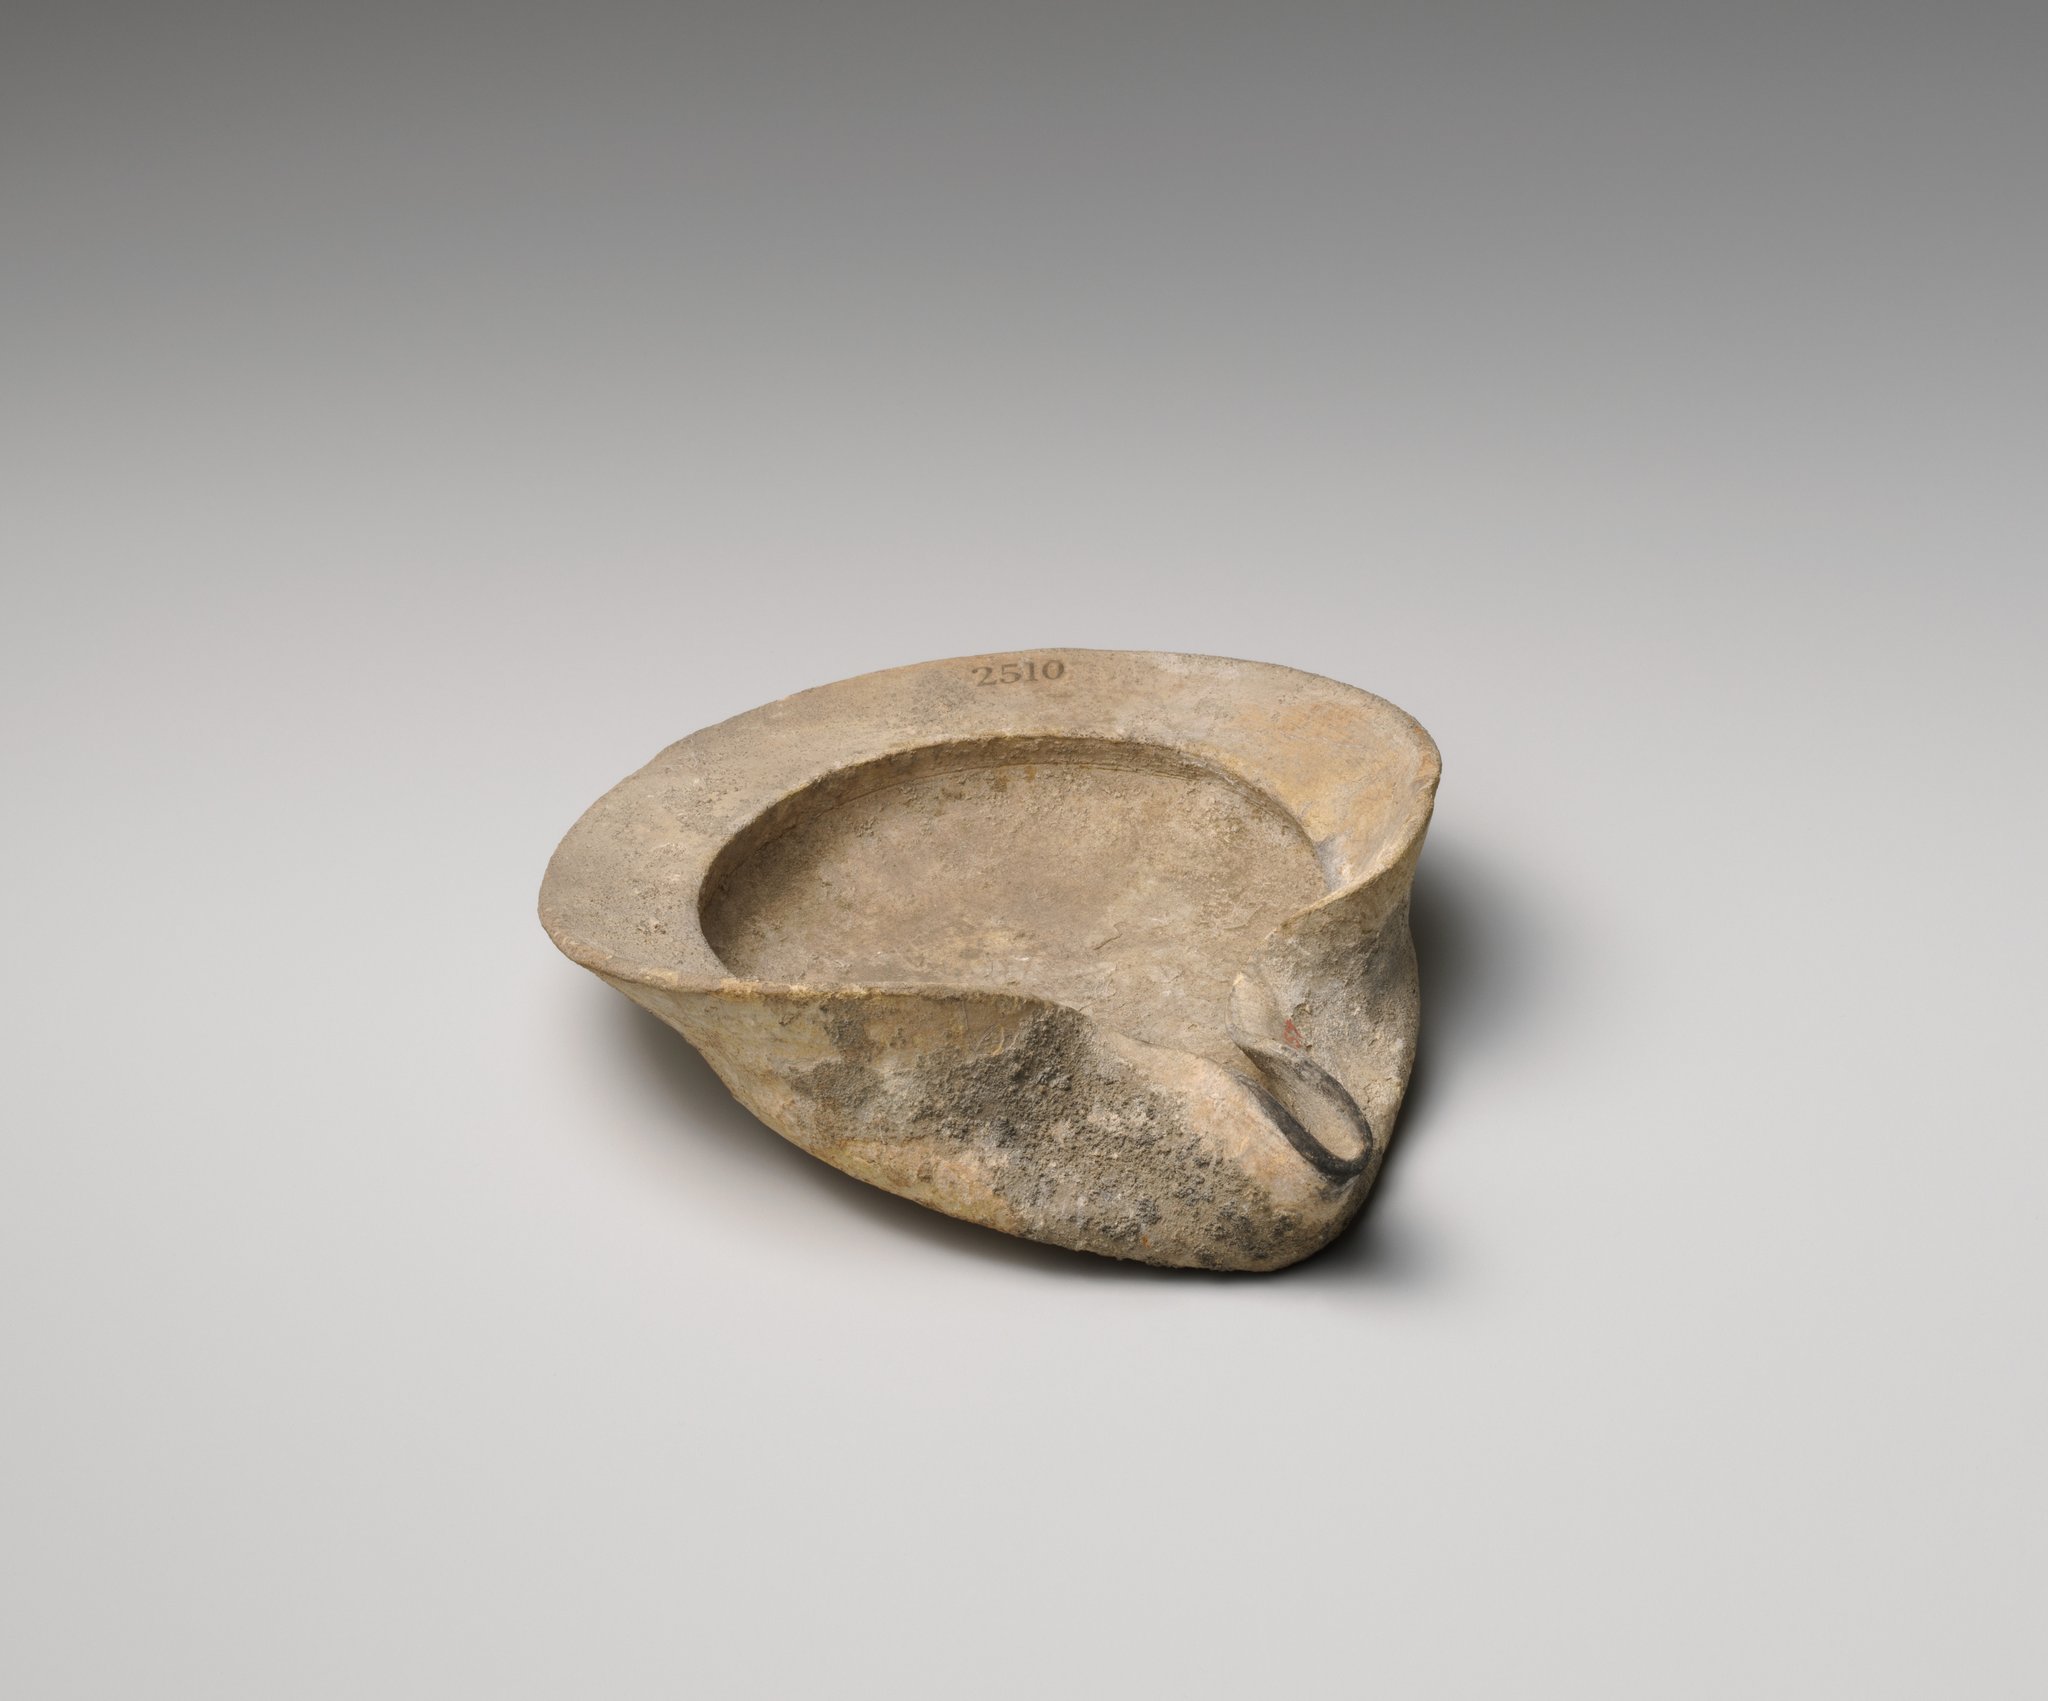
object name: lamp, saucer shaped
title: Terracotta saucer-shaped oil lamp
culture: cypriot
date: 400-301 BCE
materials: terracotta